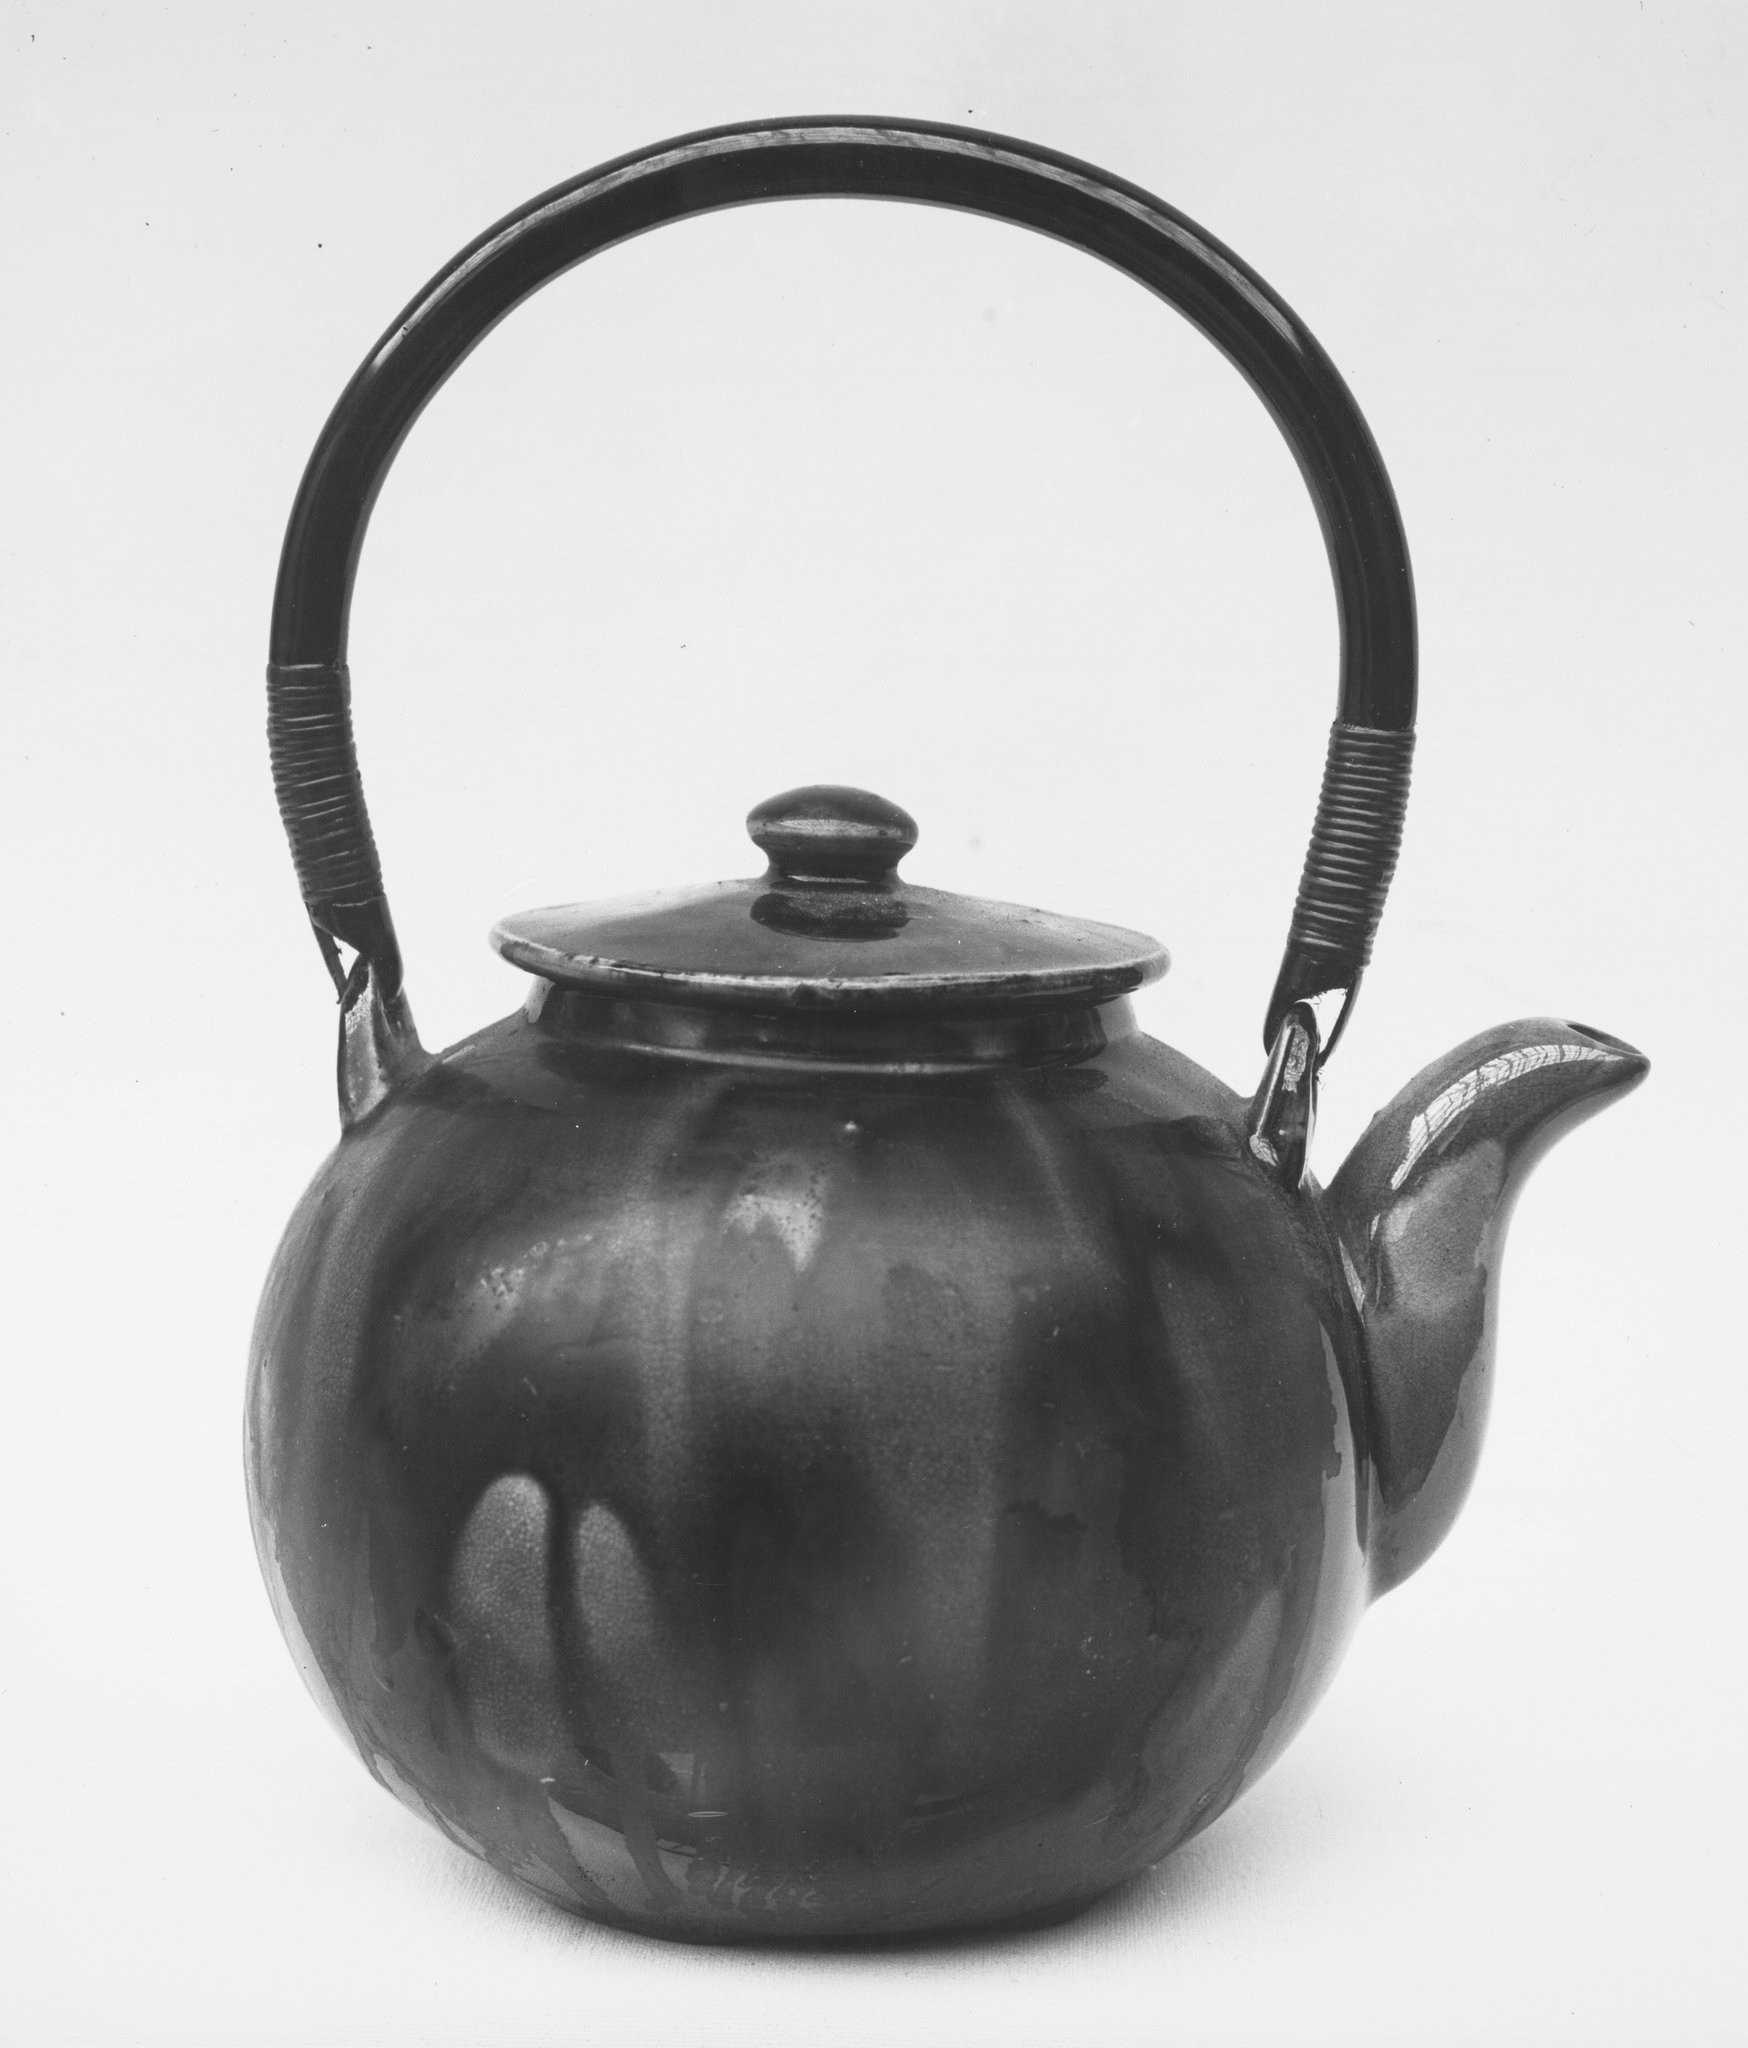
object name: teapot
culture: japanese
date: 1800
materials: clay, glaze